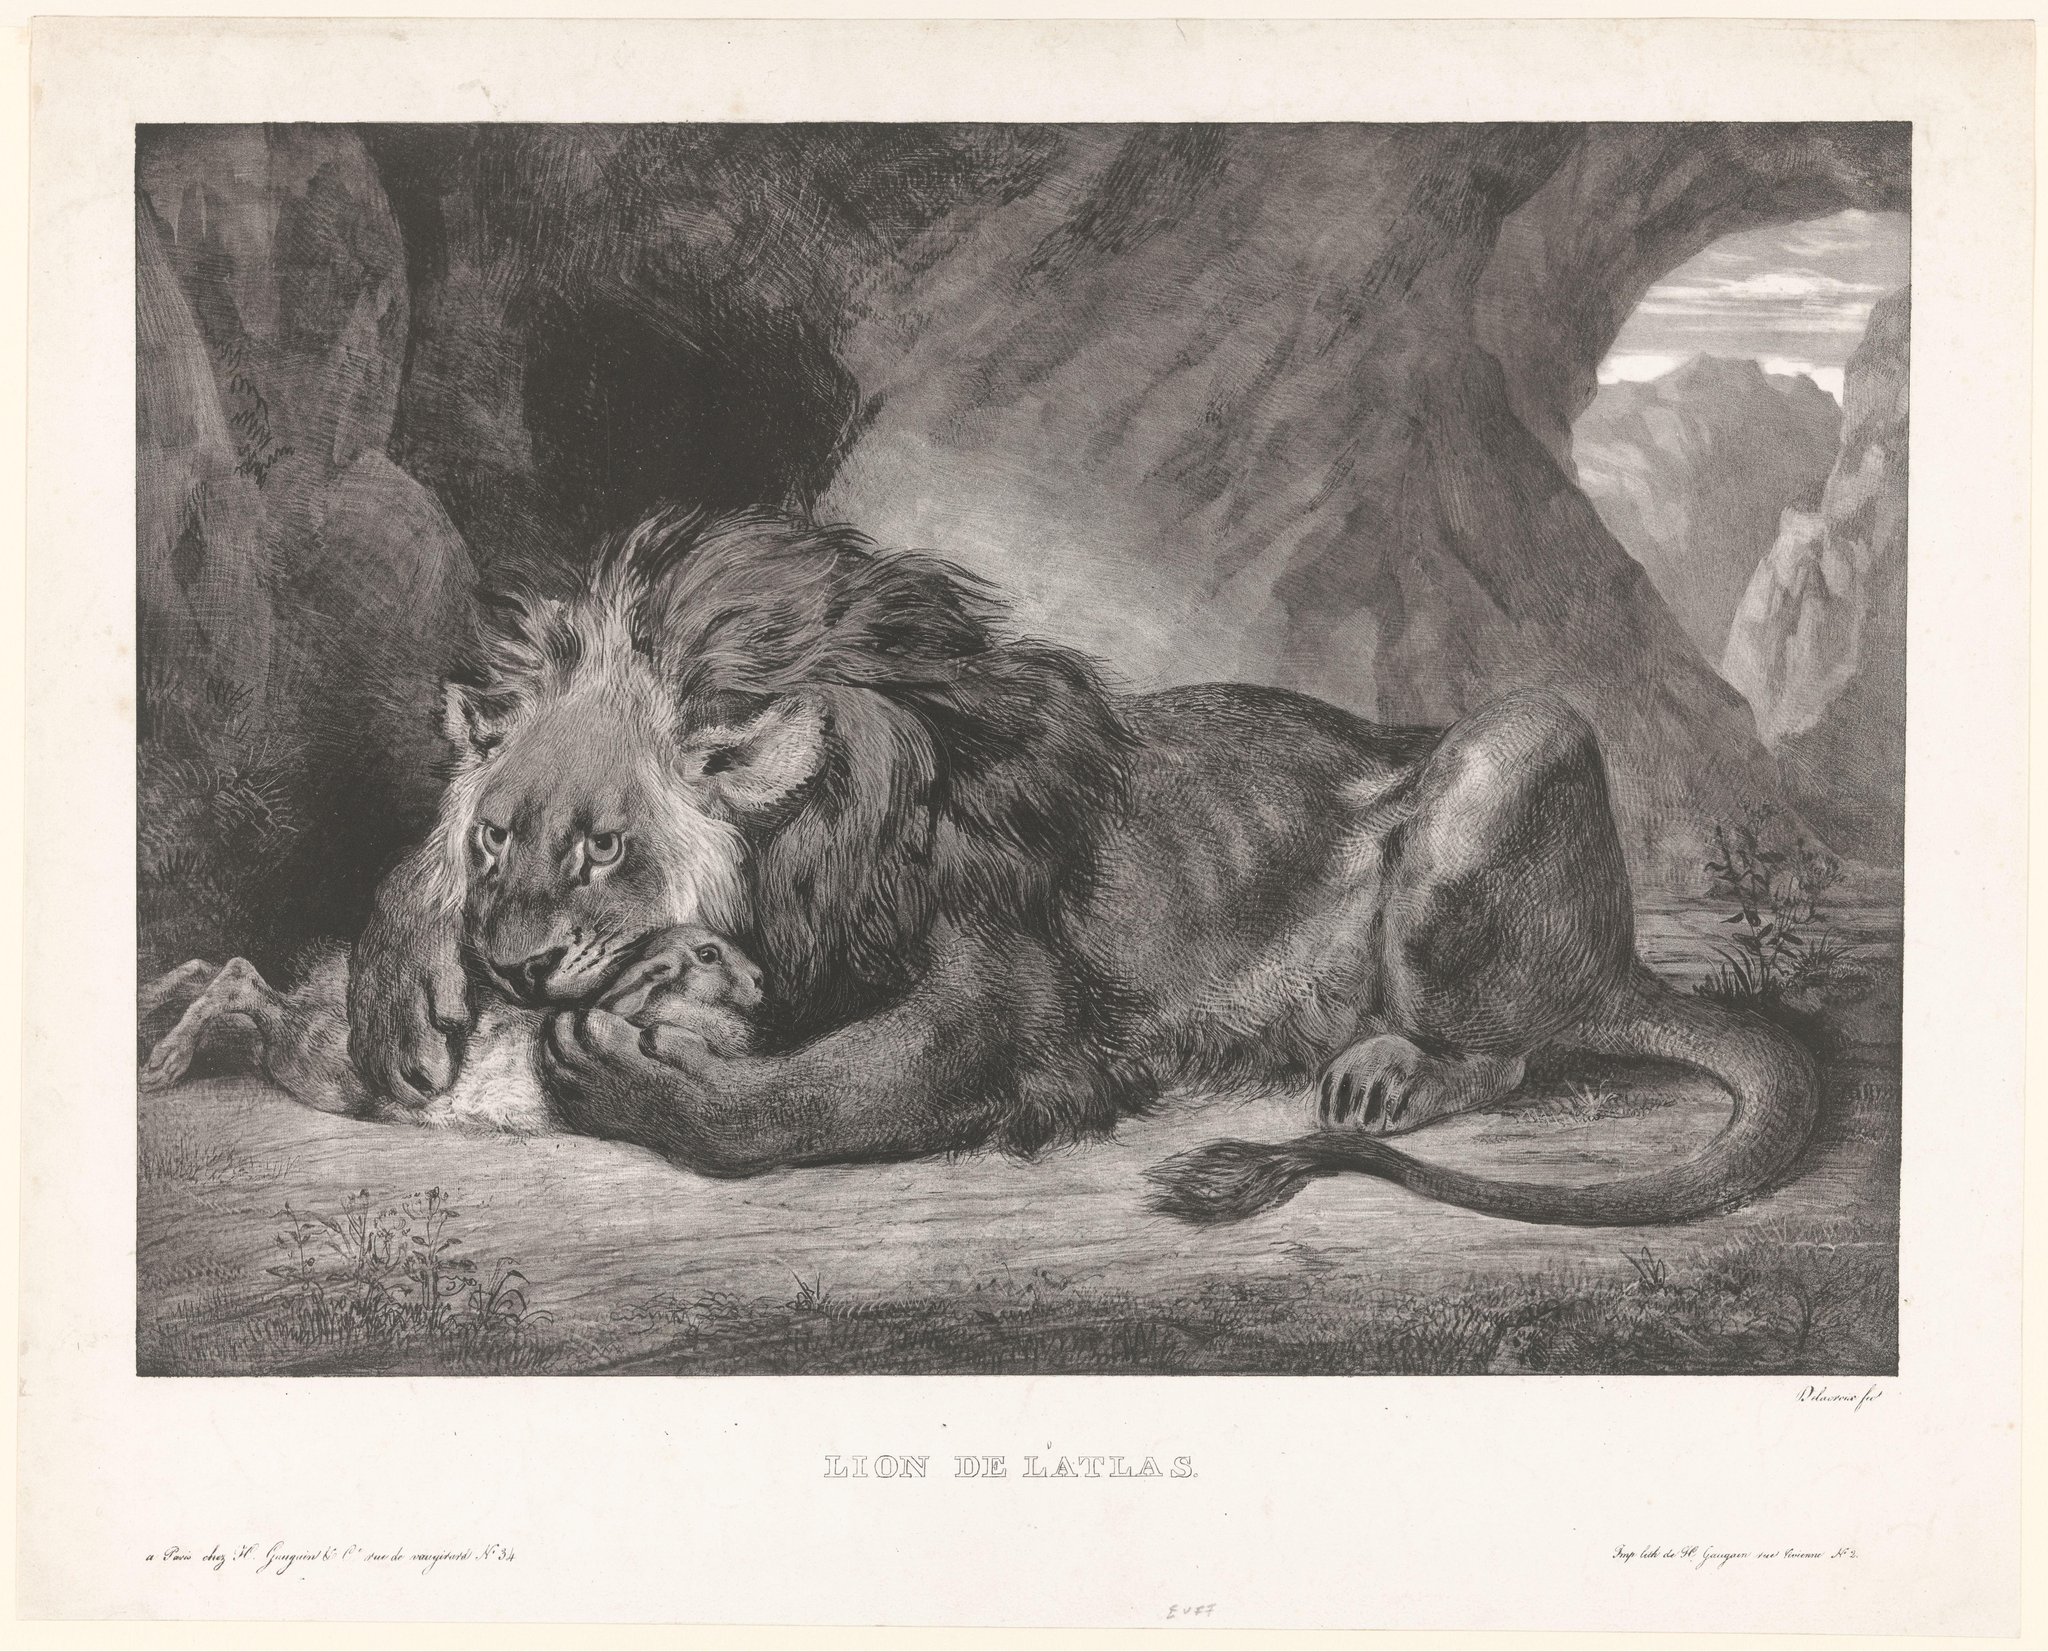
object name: print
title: Lion de l'Atlas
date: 1829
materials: paper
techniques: lithograph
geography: paris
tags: beasts of prey, predatory animals: lion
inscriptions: collector's mark: Lugt 2228a, collector's mark: Lugt 2760